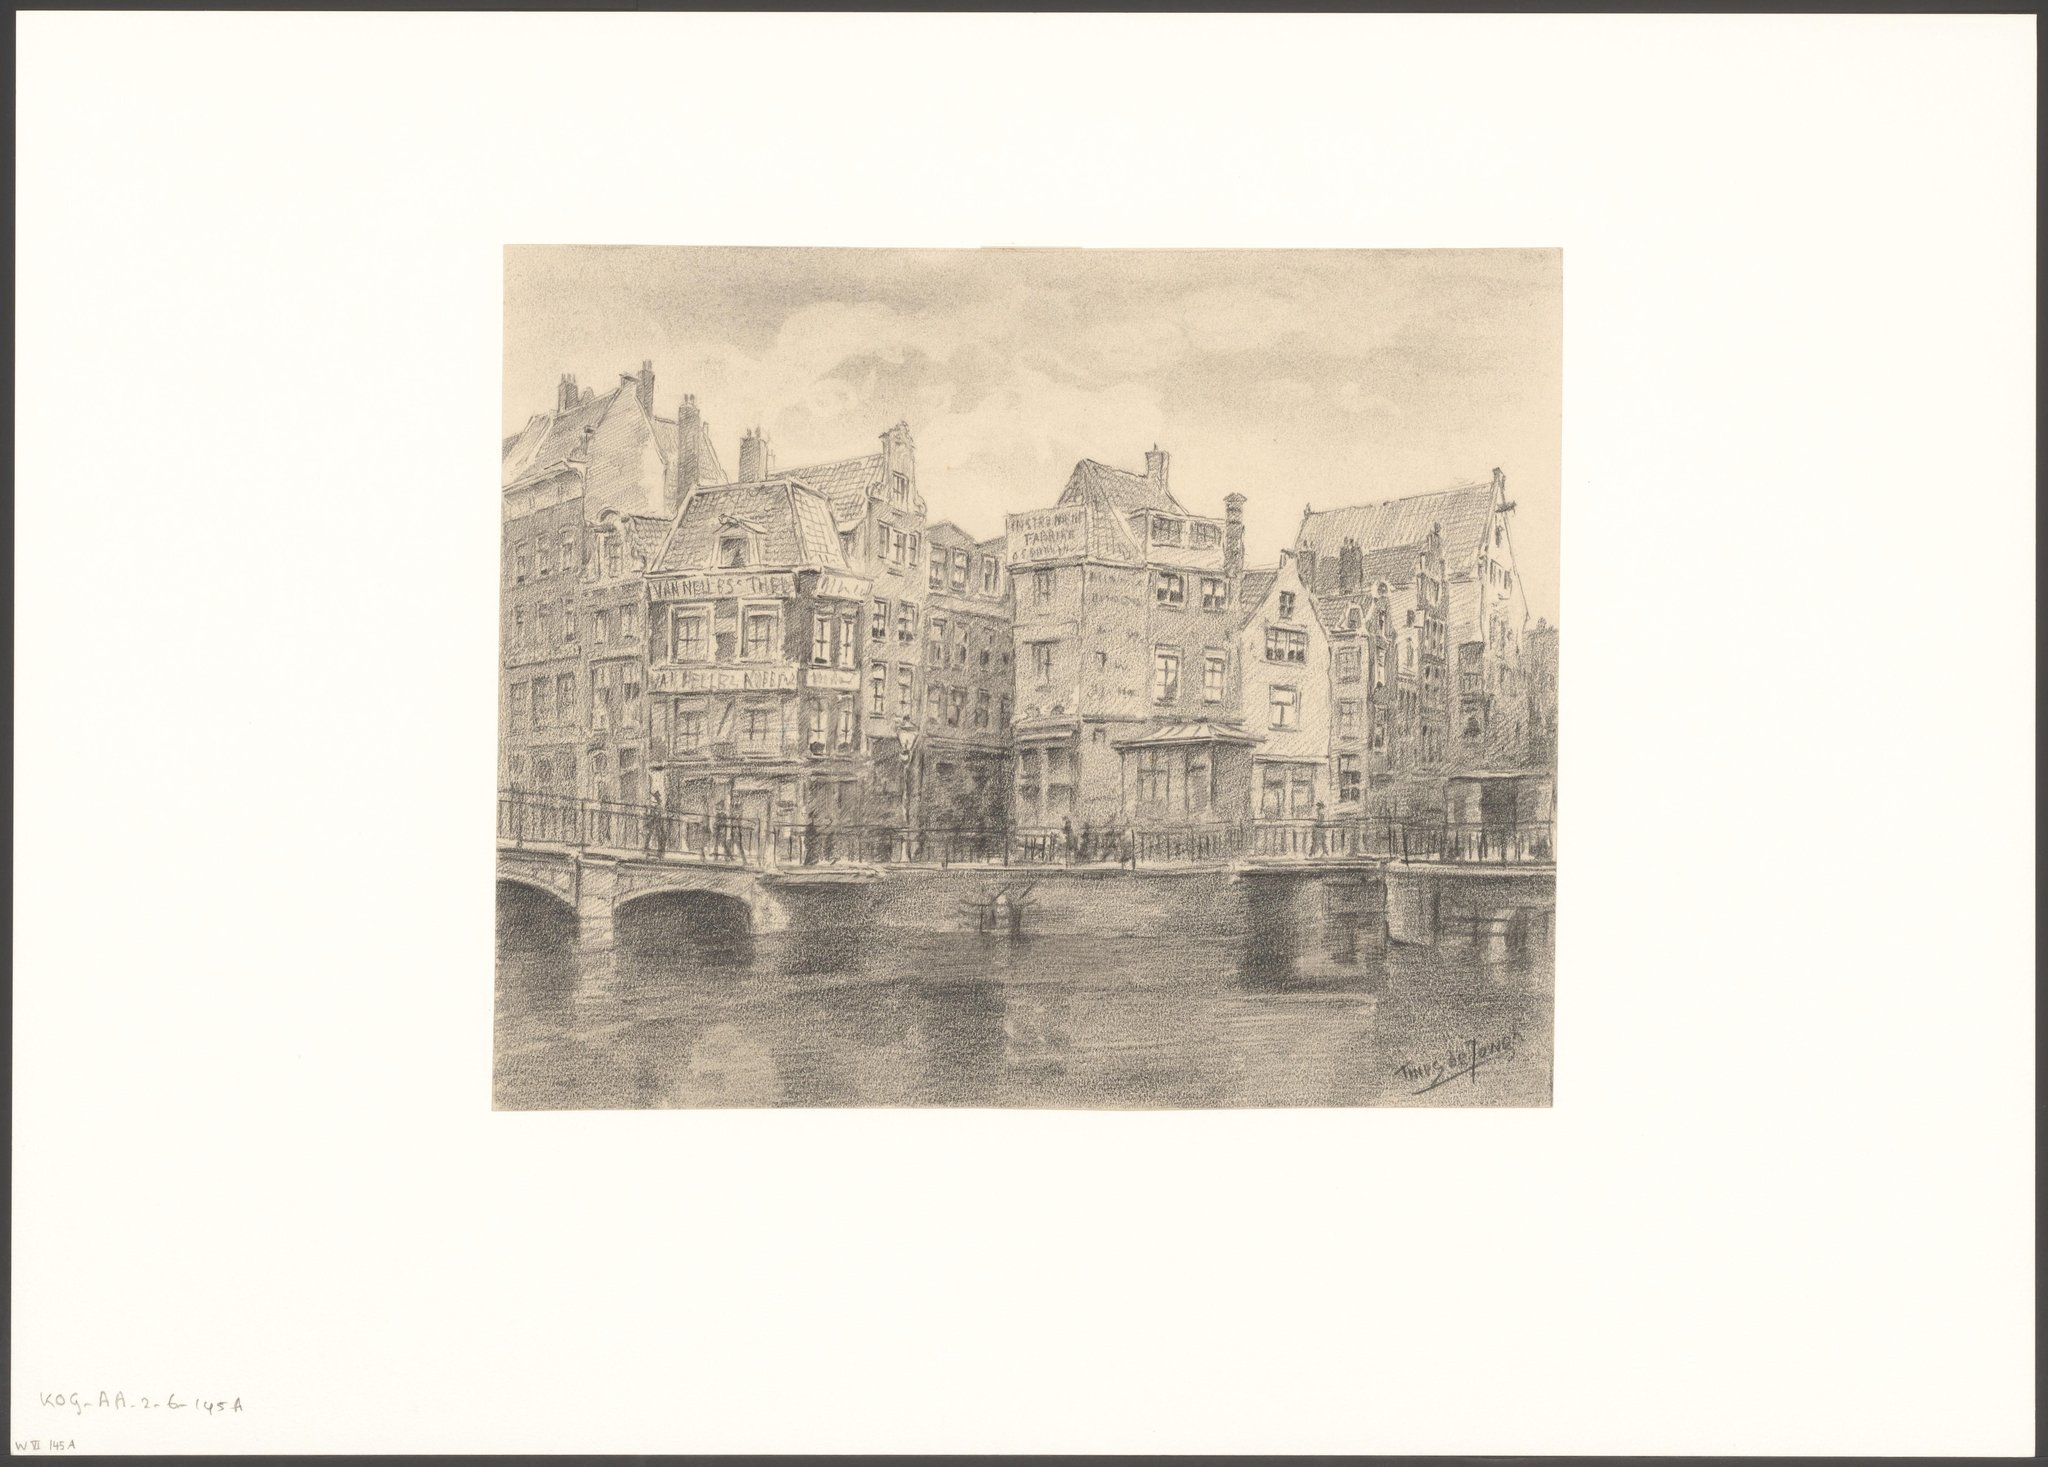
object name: drawing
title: Gezicht op het Rokin bij de ingang van de Langebrugsteeg en de Grimnessesluis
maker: tinus de jongh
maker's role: print maker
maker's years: 1885-1942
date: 1895-1942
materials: chalk, paper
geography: amsterdam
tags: city-view in general; 'veduta', canal, façade (of house or building), bridge in city across river, canal, etc.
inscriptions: signature: ‘Tinus de Jongh’, collector's mark: Lugt 800a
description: Tekening binnen de Atlas Van Eck ingedeeld op wijknummer 6.